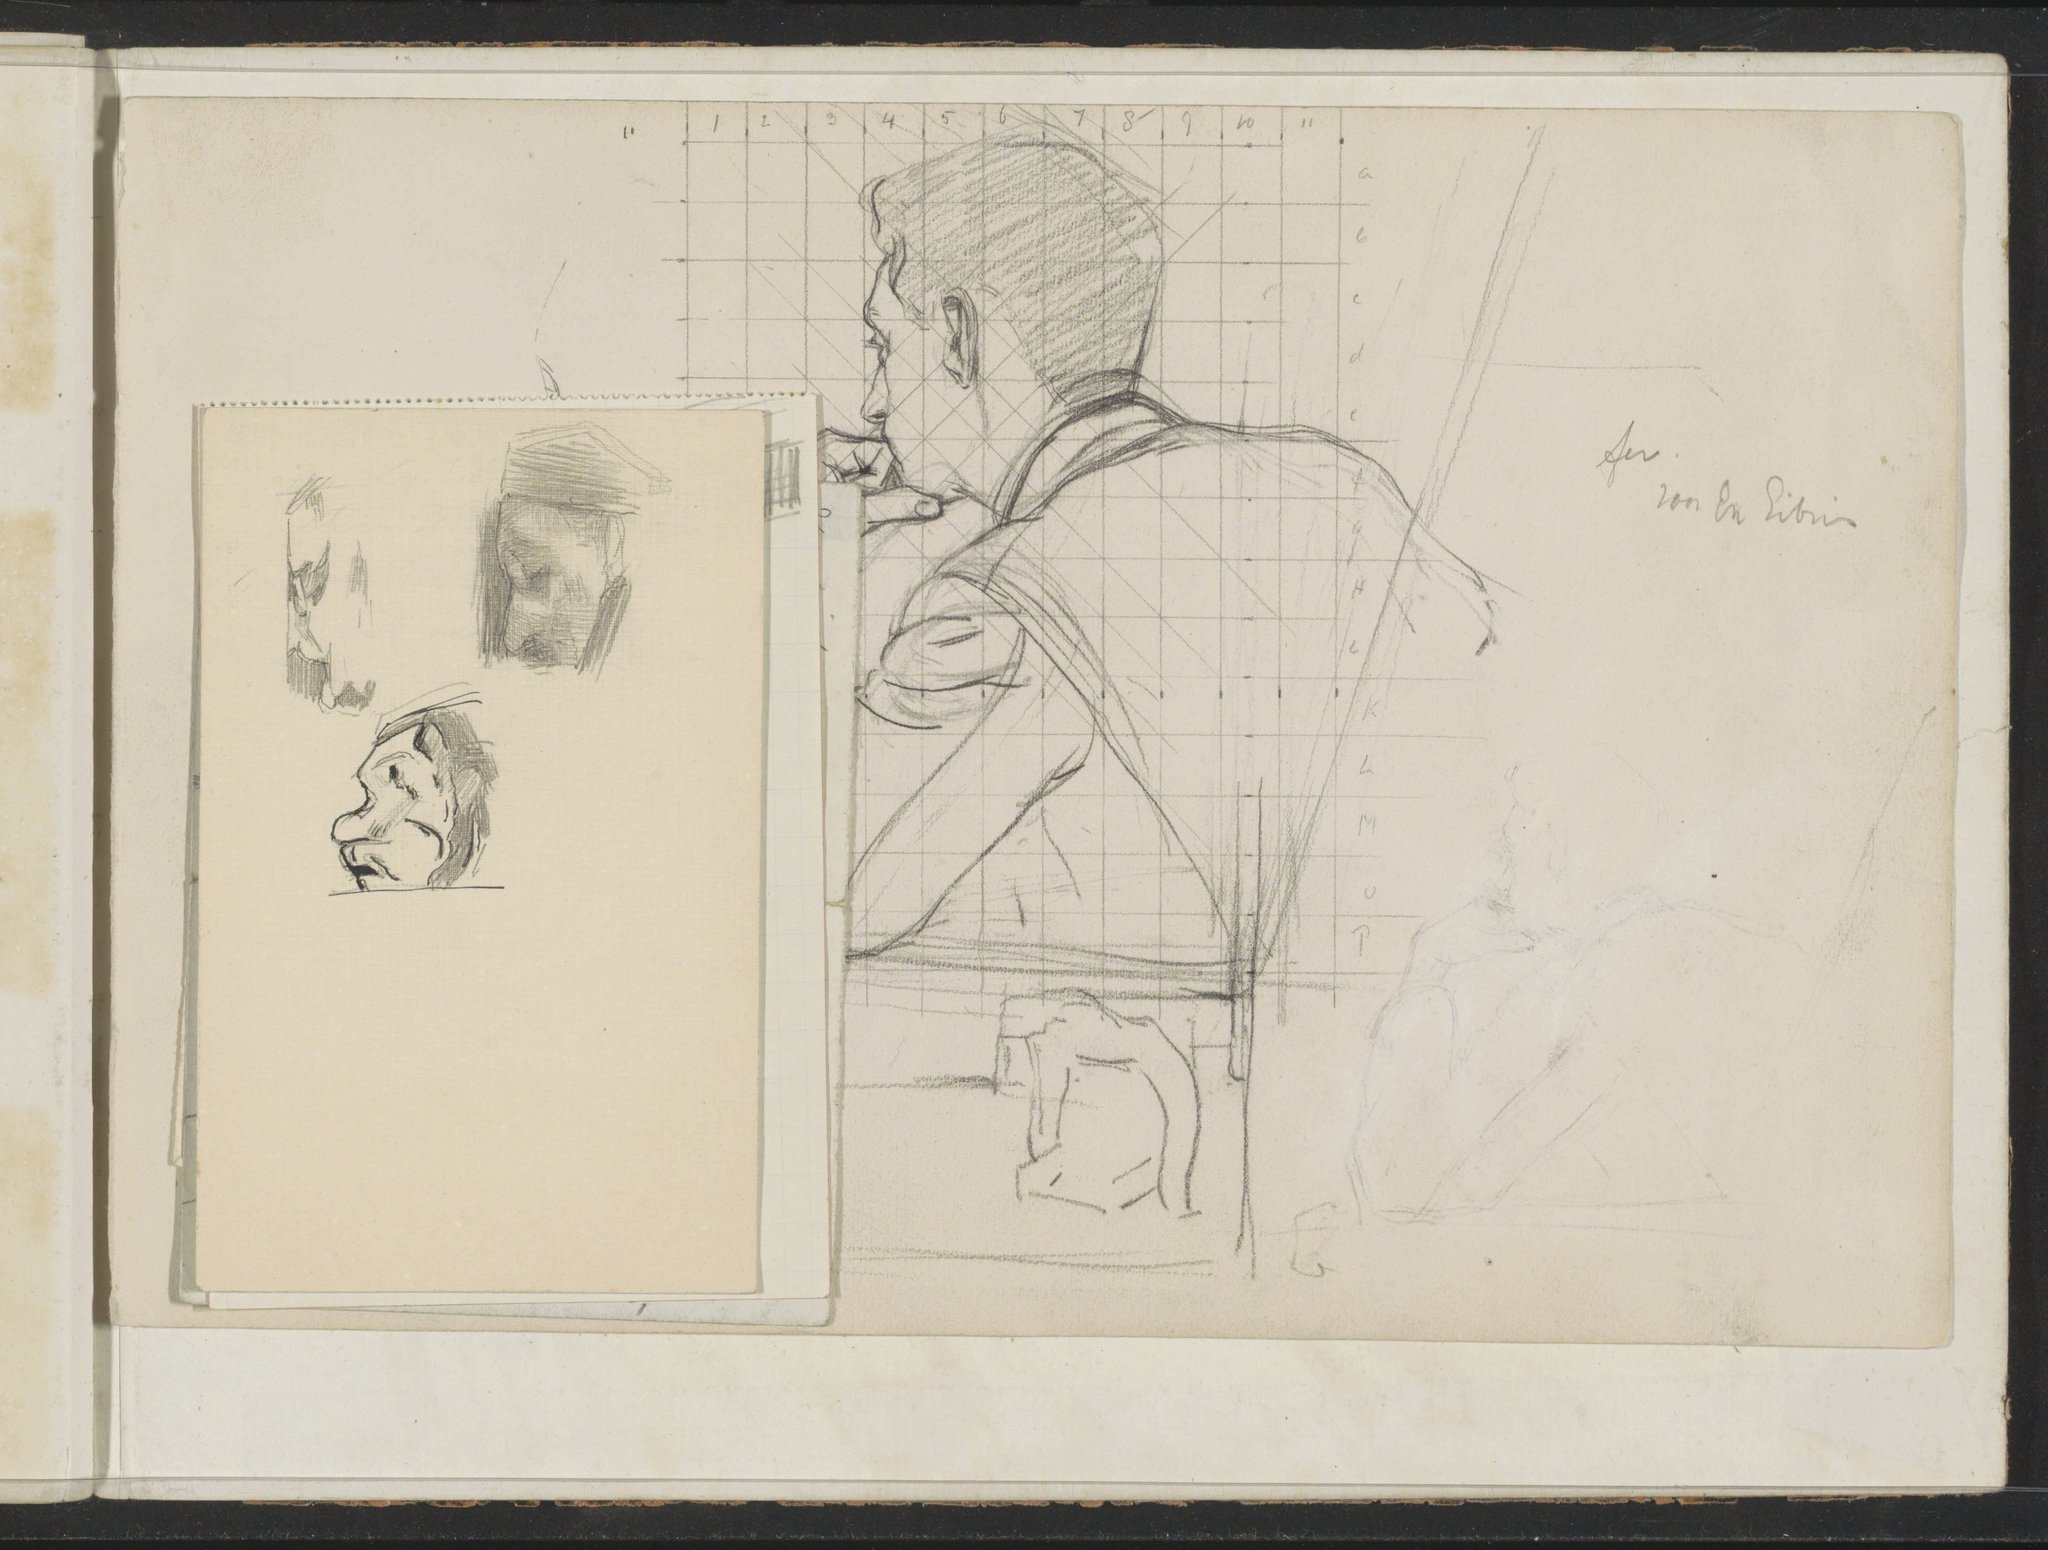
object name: sketchbook leaf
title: Drie karikaturale koppen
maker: ferdinand oldewelt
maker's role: draughtsman, print maker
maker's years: 1857-1935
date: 1904-1912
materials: cardboard, ink, pencil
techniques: pen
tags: caricatures (human types)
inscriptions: annotation: ‘A'dam 25 Dec '28./ "Telegraaf"-prijsvraag (d.d. 23 Dec. 28.)/ De goedkoopste advertentie in Nederland is een/ speurder voor slechts een halve gulden per regel./ Abonné W. Oldewelt/ Uithoornstraat 1 h/ Amsterdam’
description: Los blad tussen blad 27 en het achterste schutblad uit een schetsboek met 27 bladen.